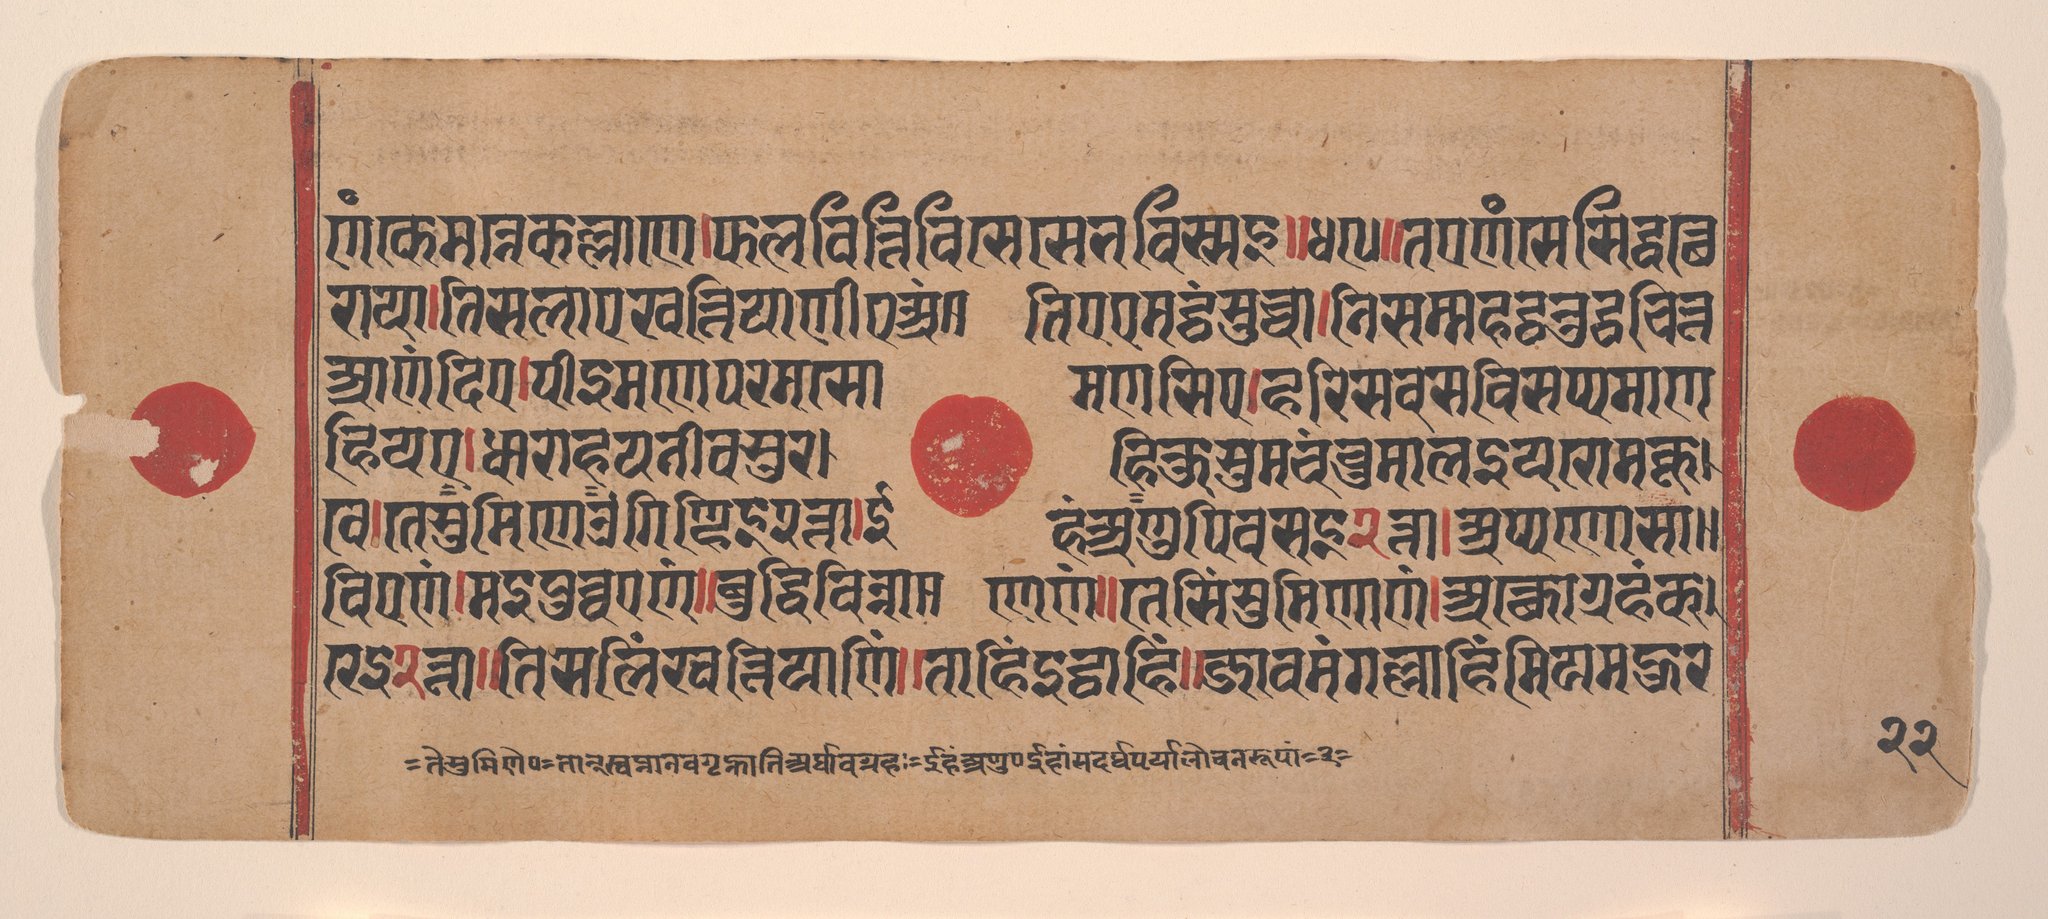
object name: folio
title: Page from a Dispersed Kalpa Sutra (Jain Book of Rituals)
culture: indian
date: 1401-1500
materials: gold, ink, paper, watercolor